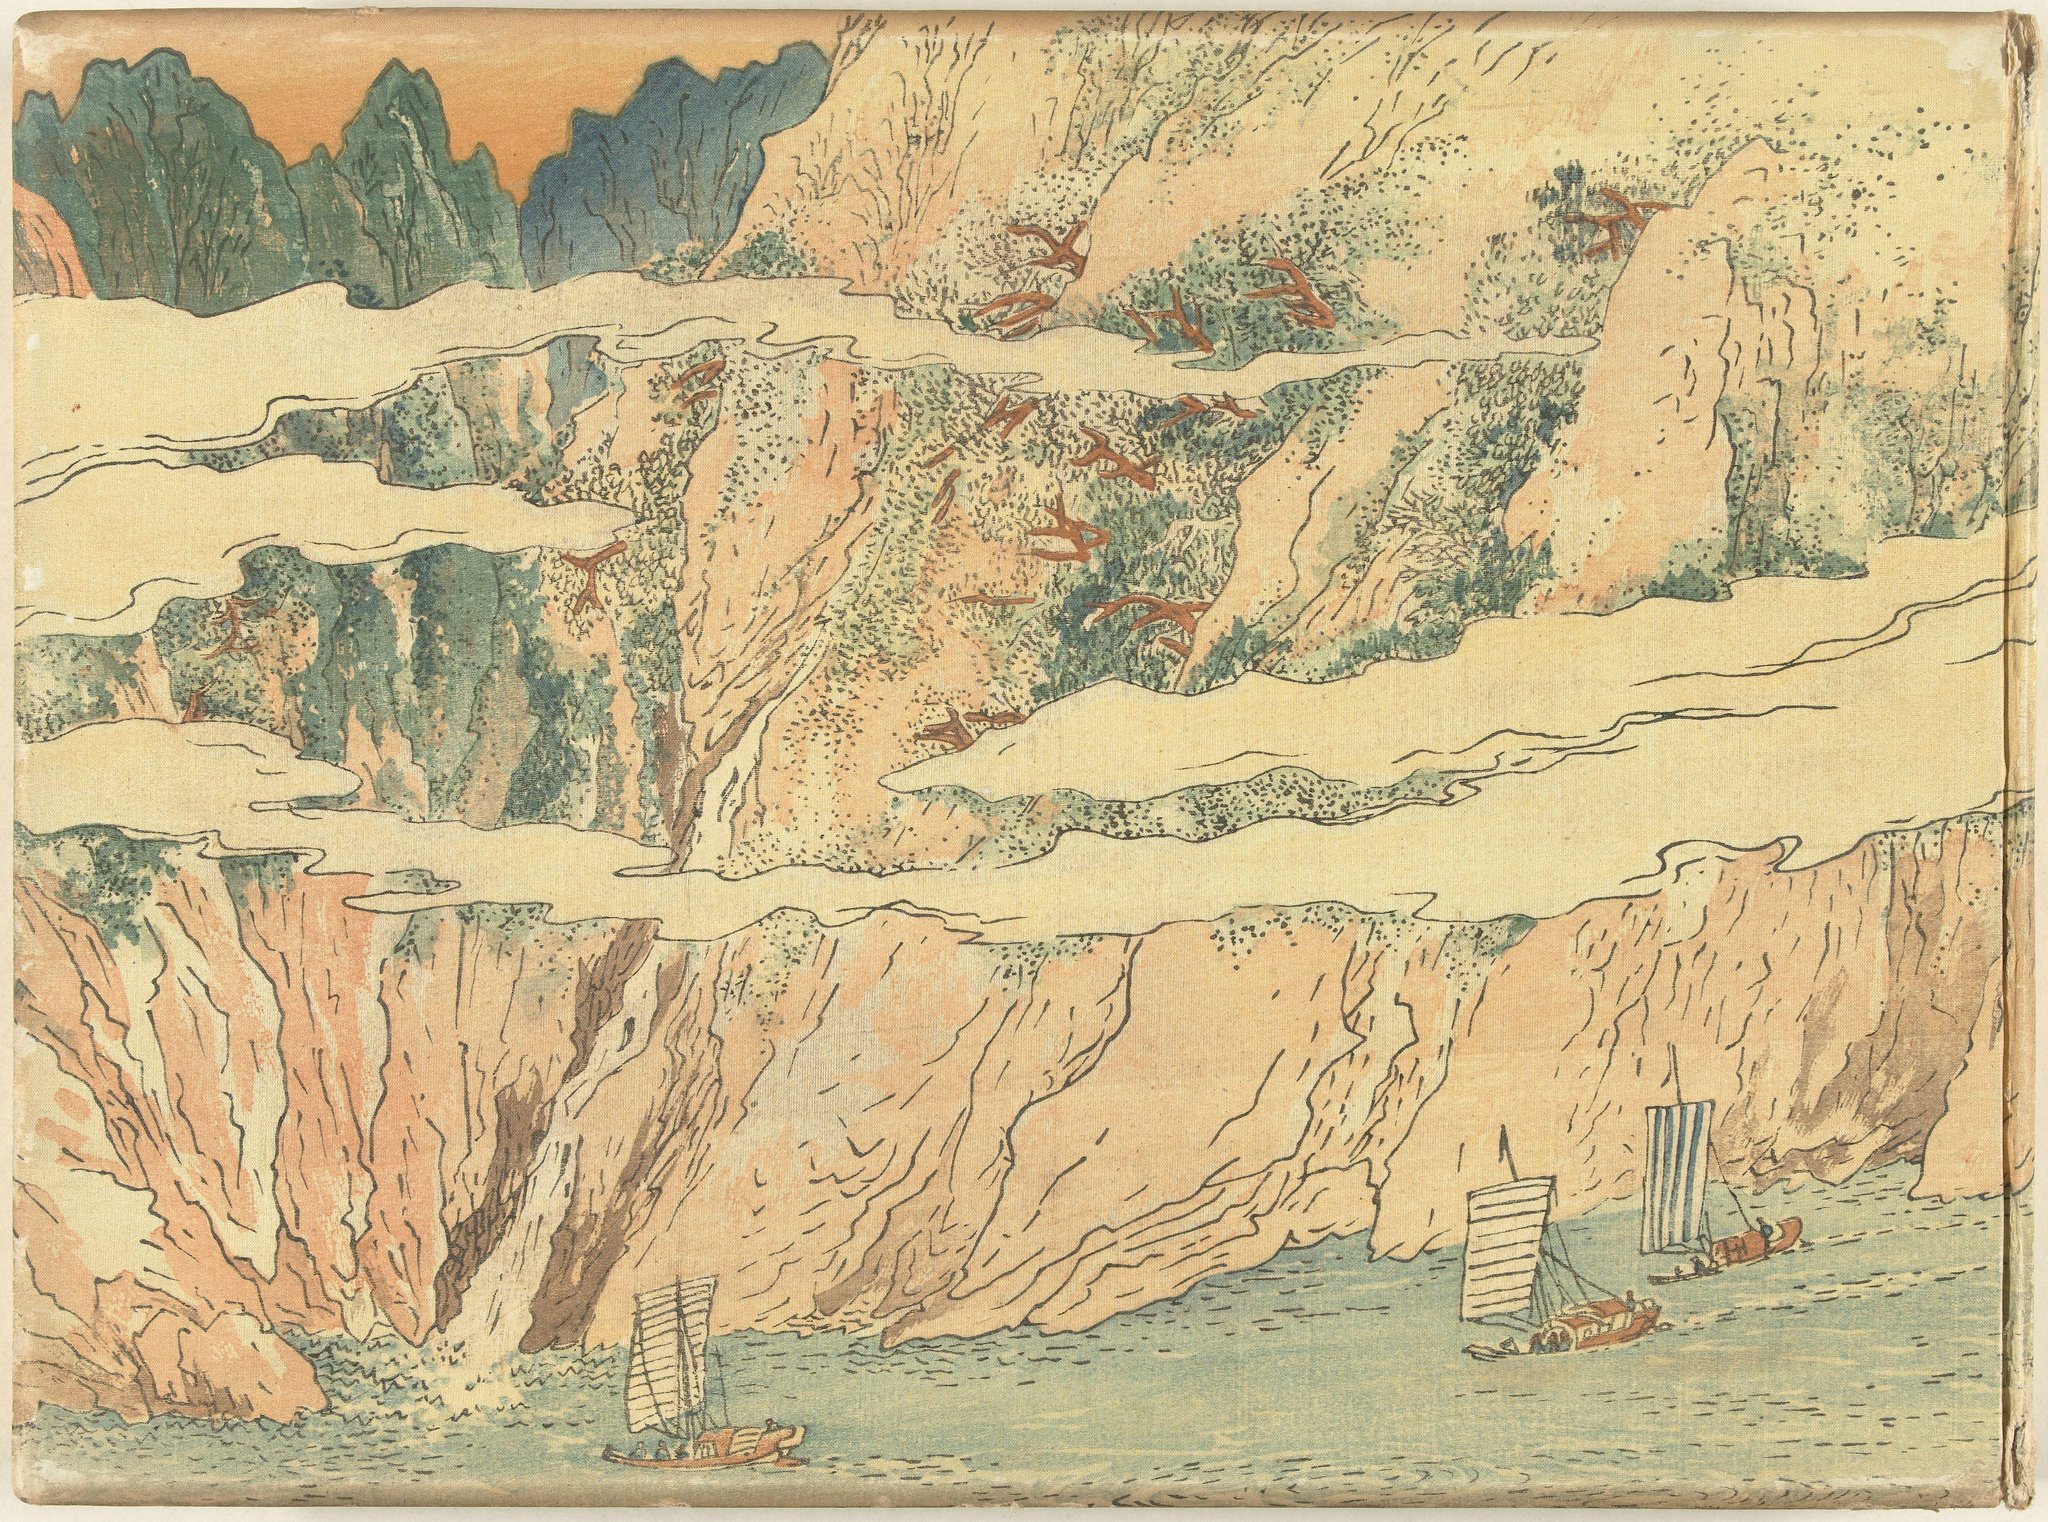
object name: book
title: Shina sanju gakan - gekan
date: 1920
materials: paper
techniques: photograph, woodcut, letterpress printing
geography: tokyo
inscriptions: date